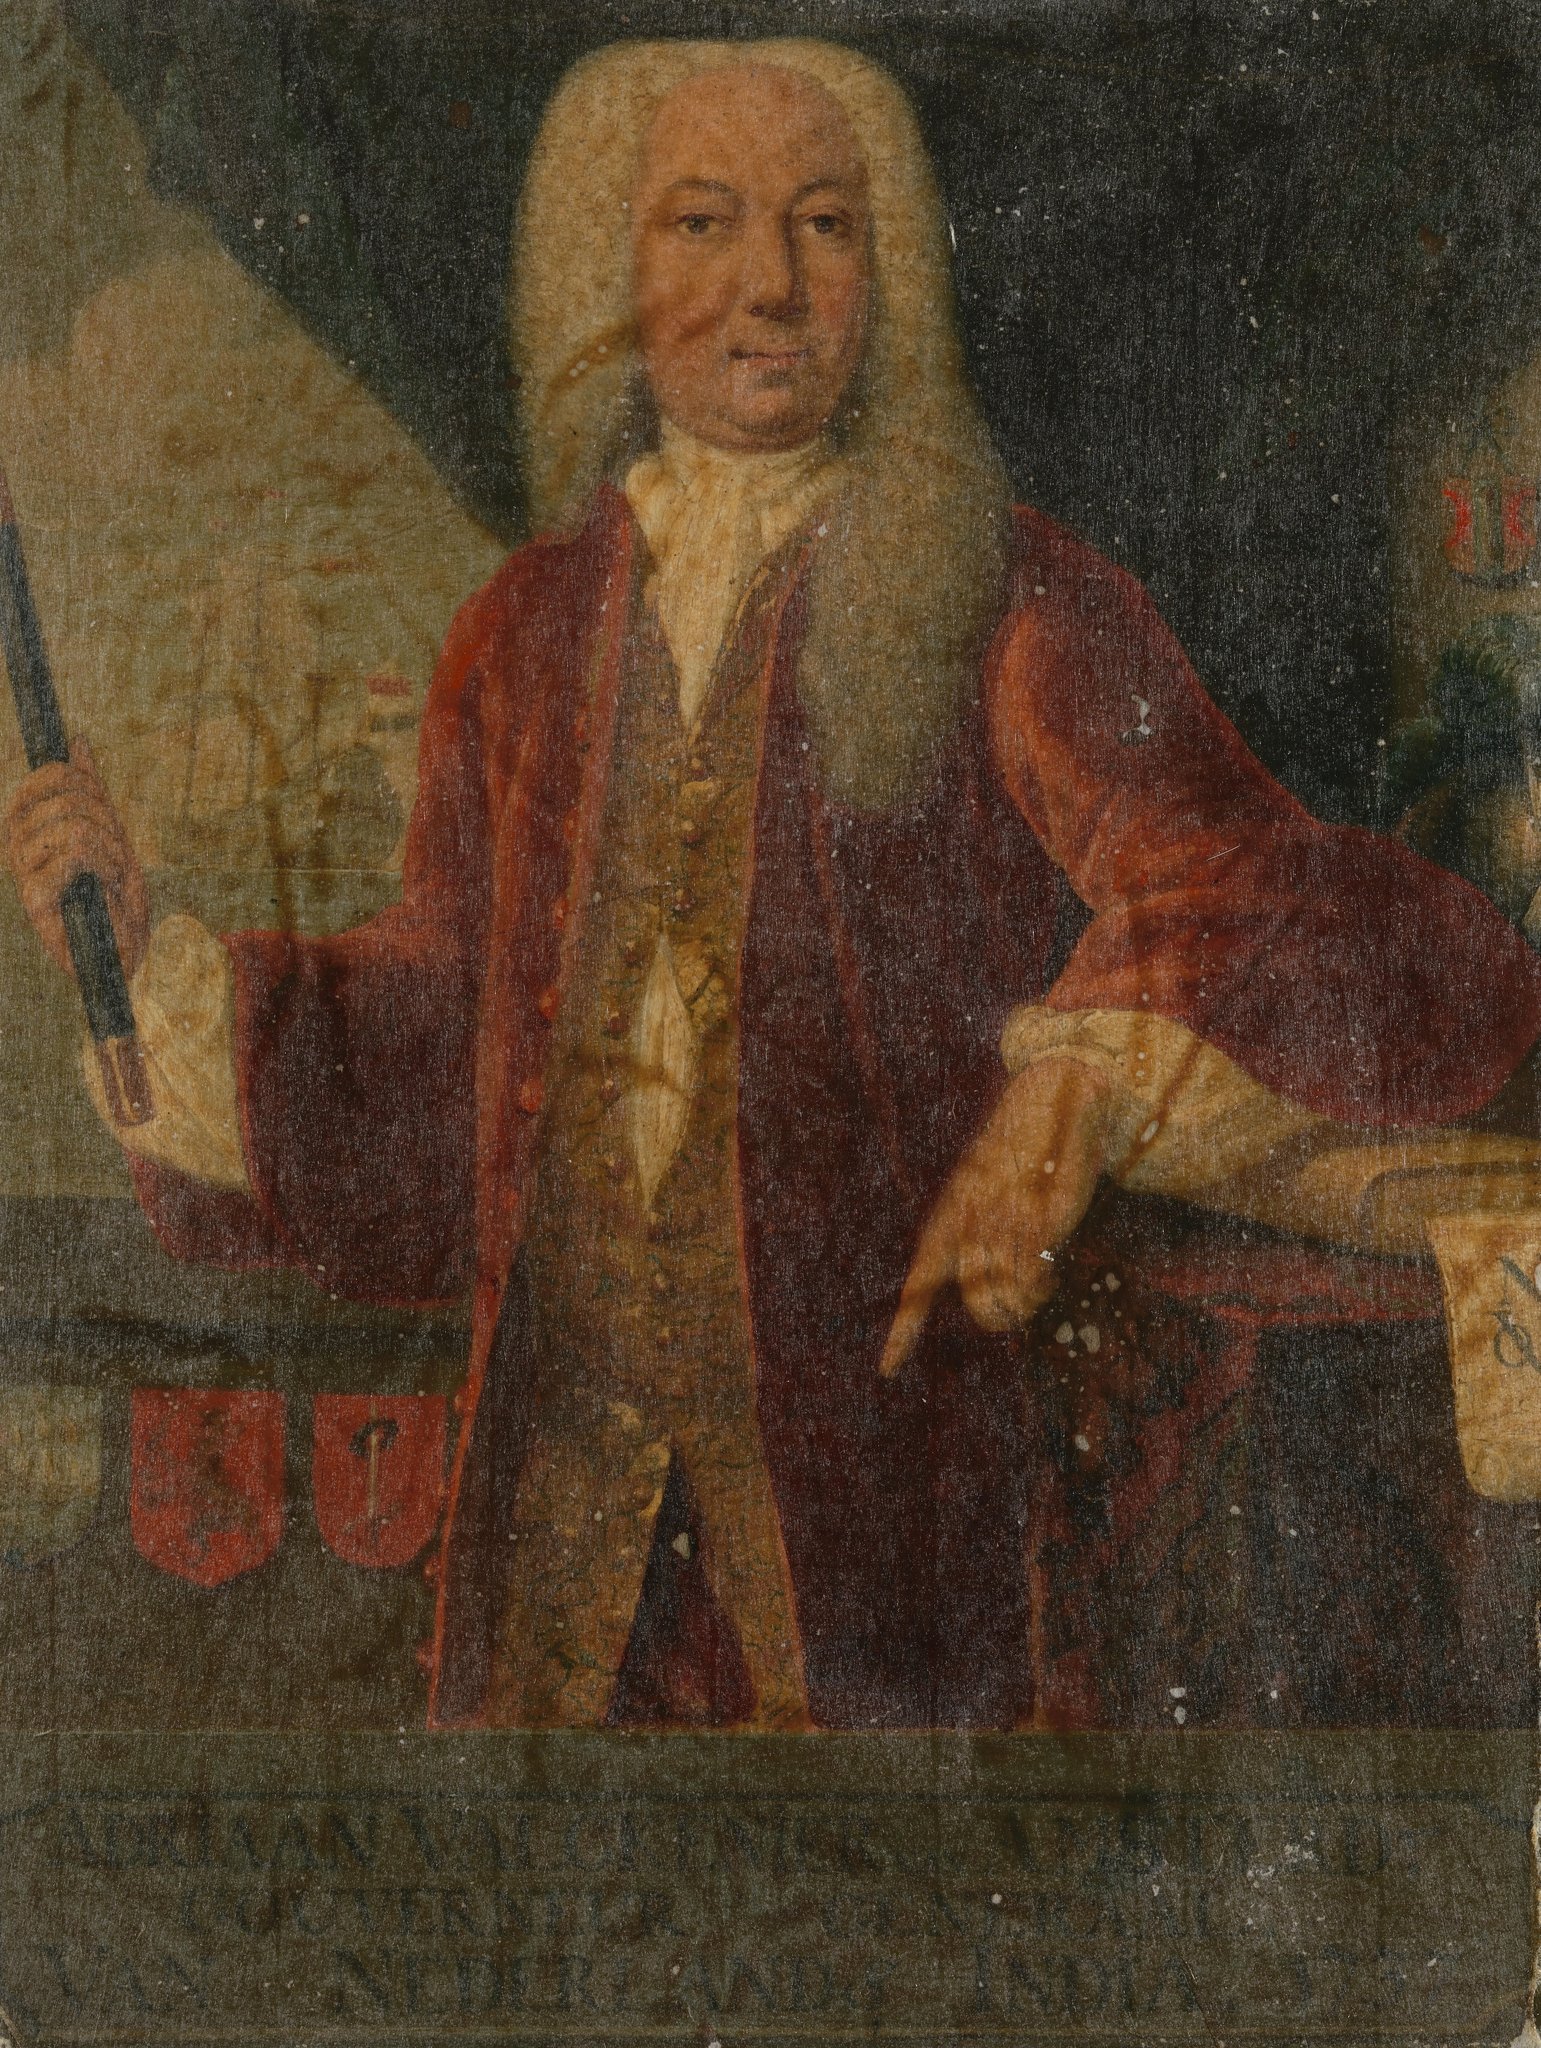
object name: painting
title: Portrait of Adriaan Valckenier, Governor-General of the Dutch East India Company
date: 1750-1800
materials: copper, oil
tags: verenigde oostindische compagnie, gouverneur-generaal, adriaan valckenier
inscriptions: inscription: ‘Adriaan Valckenier van Amsterd. Gouverneur Generaal. Van Nederlands India, 1737’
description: Portret van Adriaan Valckenier (1695-1751). Gouverneur-generaal (1737-41). Staande, ten halven lijve, naar links, het gelaat aanziend. Commandostaf in de rechterhand, met de linkerarm rustend op een boek met een papier waarop het monogram van de VOC. Rechtsboven het familiewapen, linksonder de wapens van Nederlands Oost-Indië, de Republiek en Batavia. Op de achtergrond een schip op zee. Onderdeel van een reeks van kopieën naar portretten van de gouverneurs-generaal van het voormalige Nederlands Oost-Indië, waarschijnlijk afkomstig van de Verenigde Oostindische Compagnie. Kopie naar SK-A-3778.